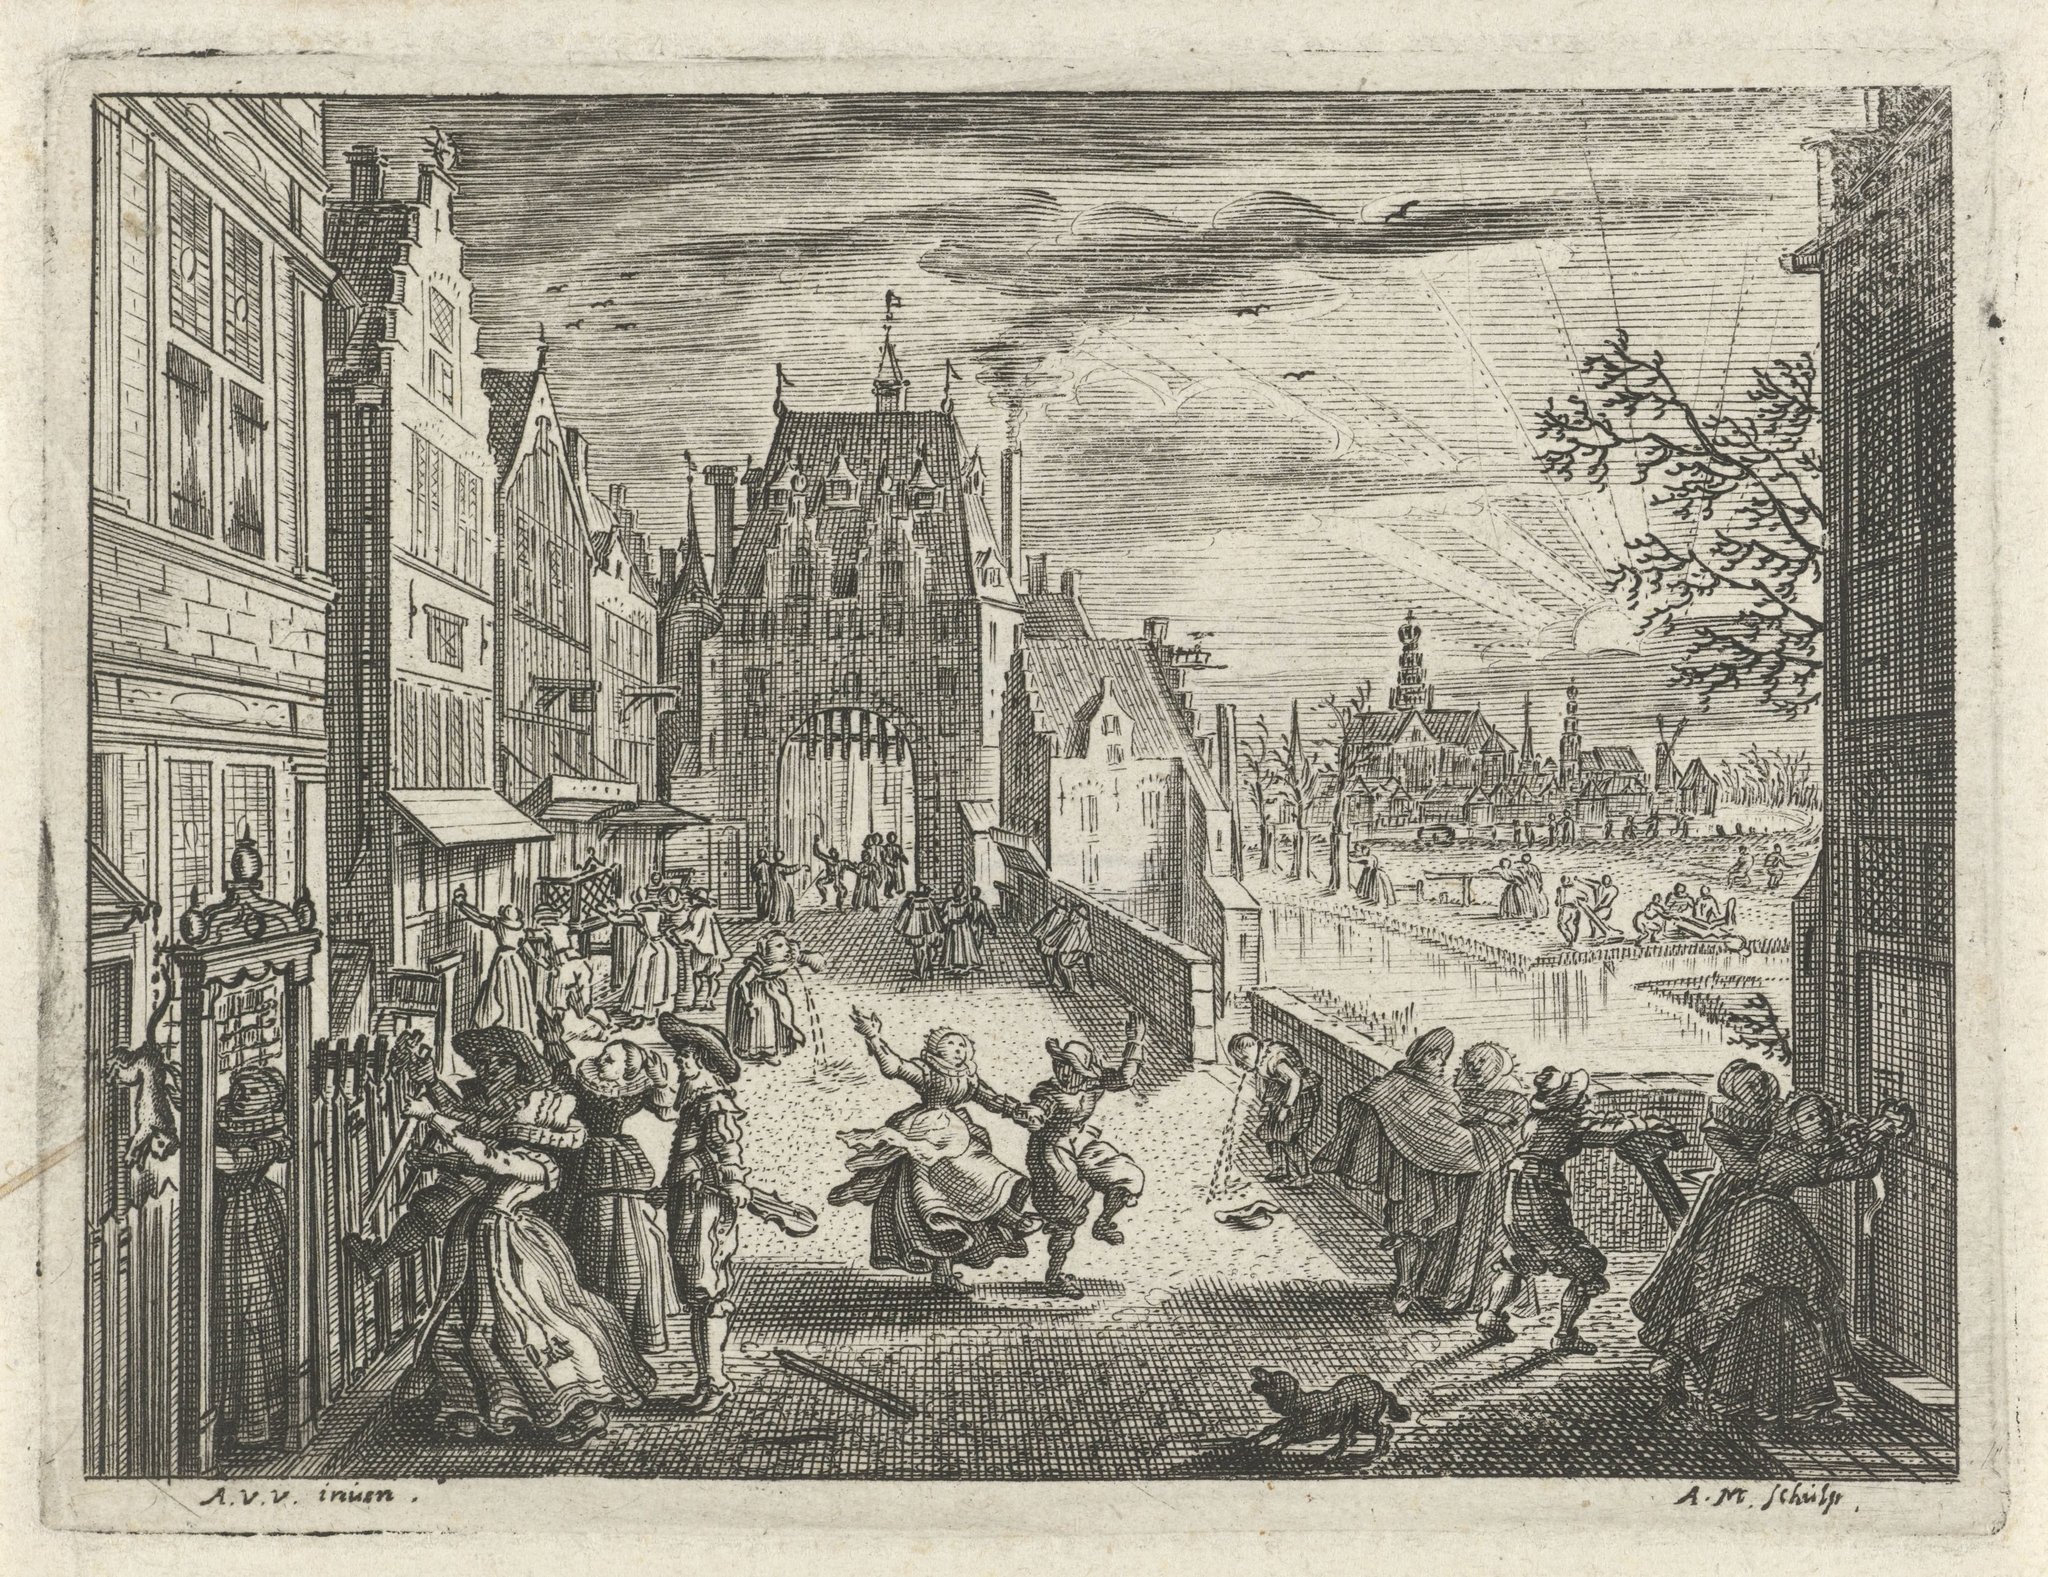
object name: print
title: Feestend gezelschap in een stad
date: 1620-1660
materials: paper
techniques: engraving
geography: northern netherlands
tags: dancing, public festivities, public road, periodic celebrations, popular feasts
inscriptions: collector's mark: Lugt 2760, collector's mark: Lugt 2228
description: Figuren in een stad met een poort. In het midden danst een paar, vele figuren kloppen op deuren, een vrouw braakt in de straat.